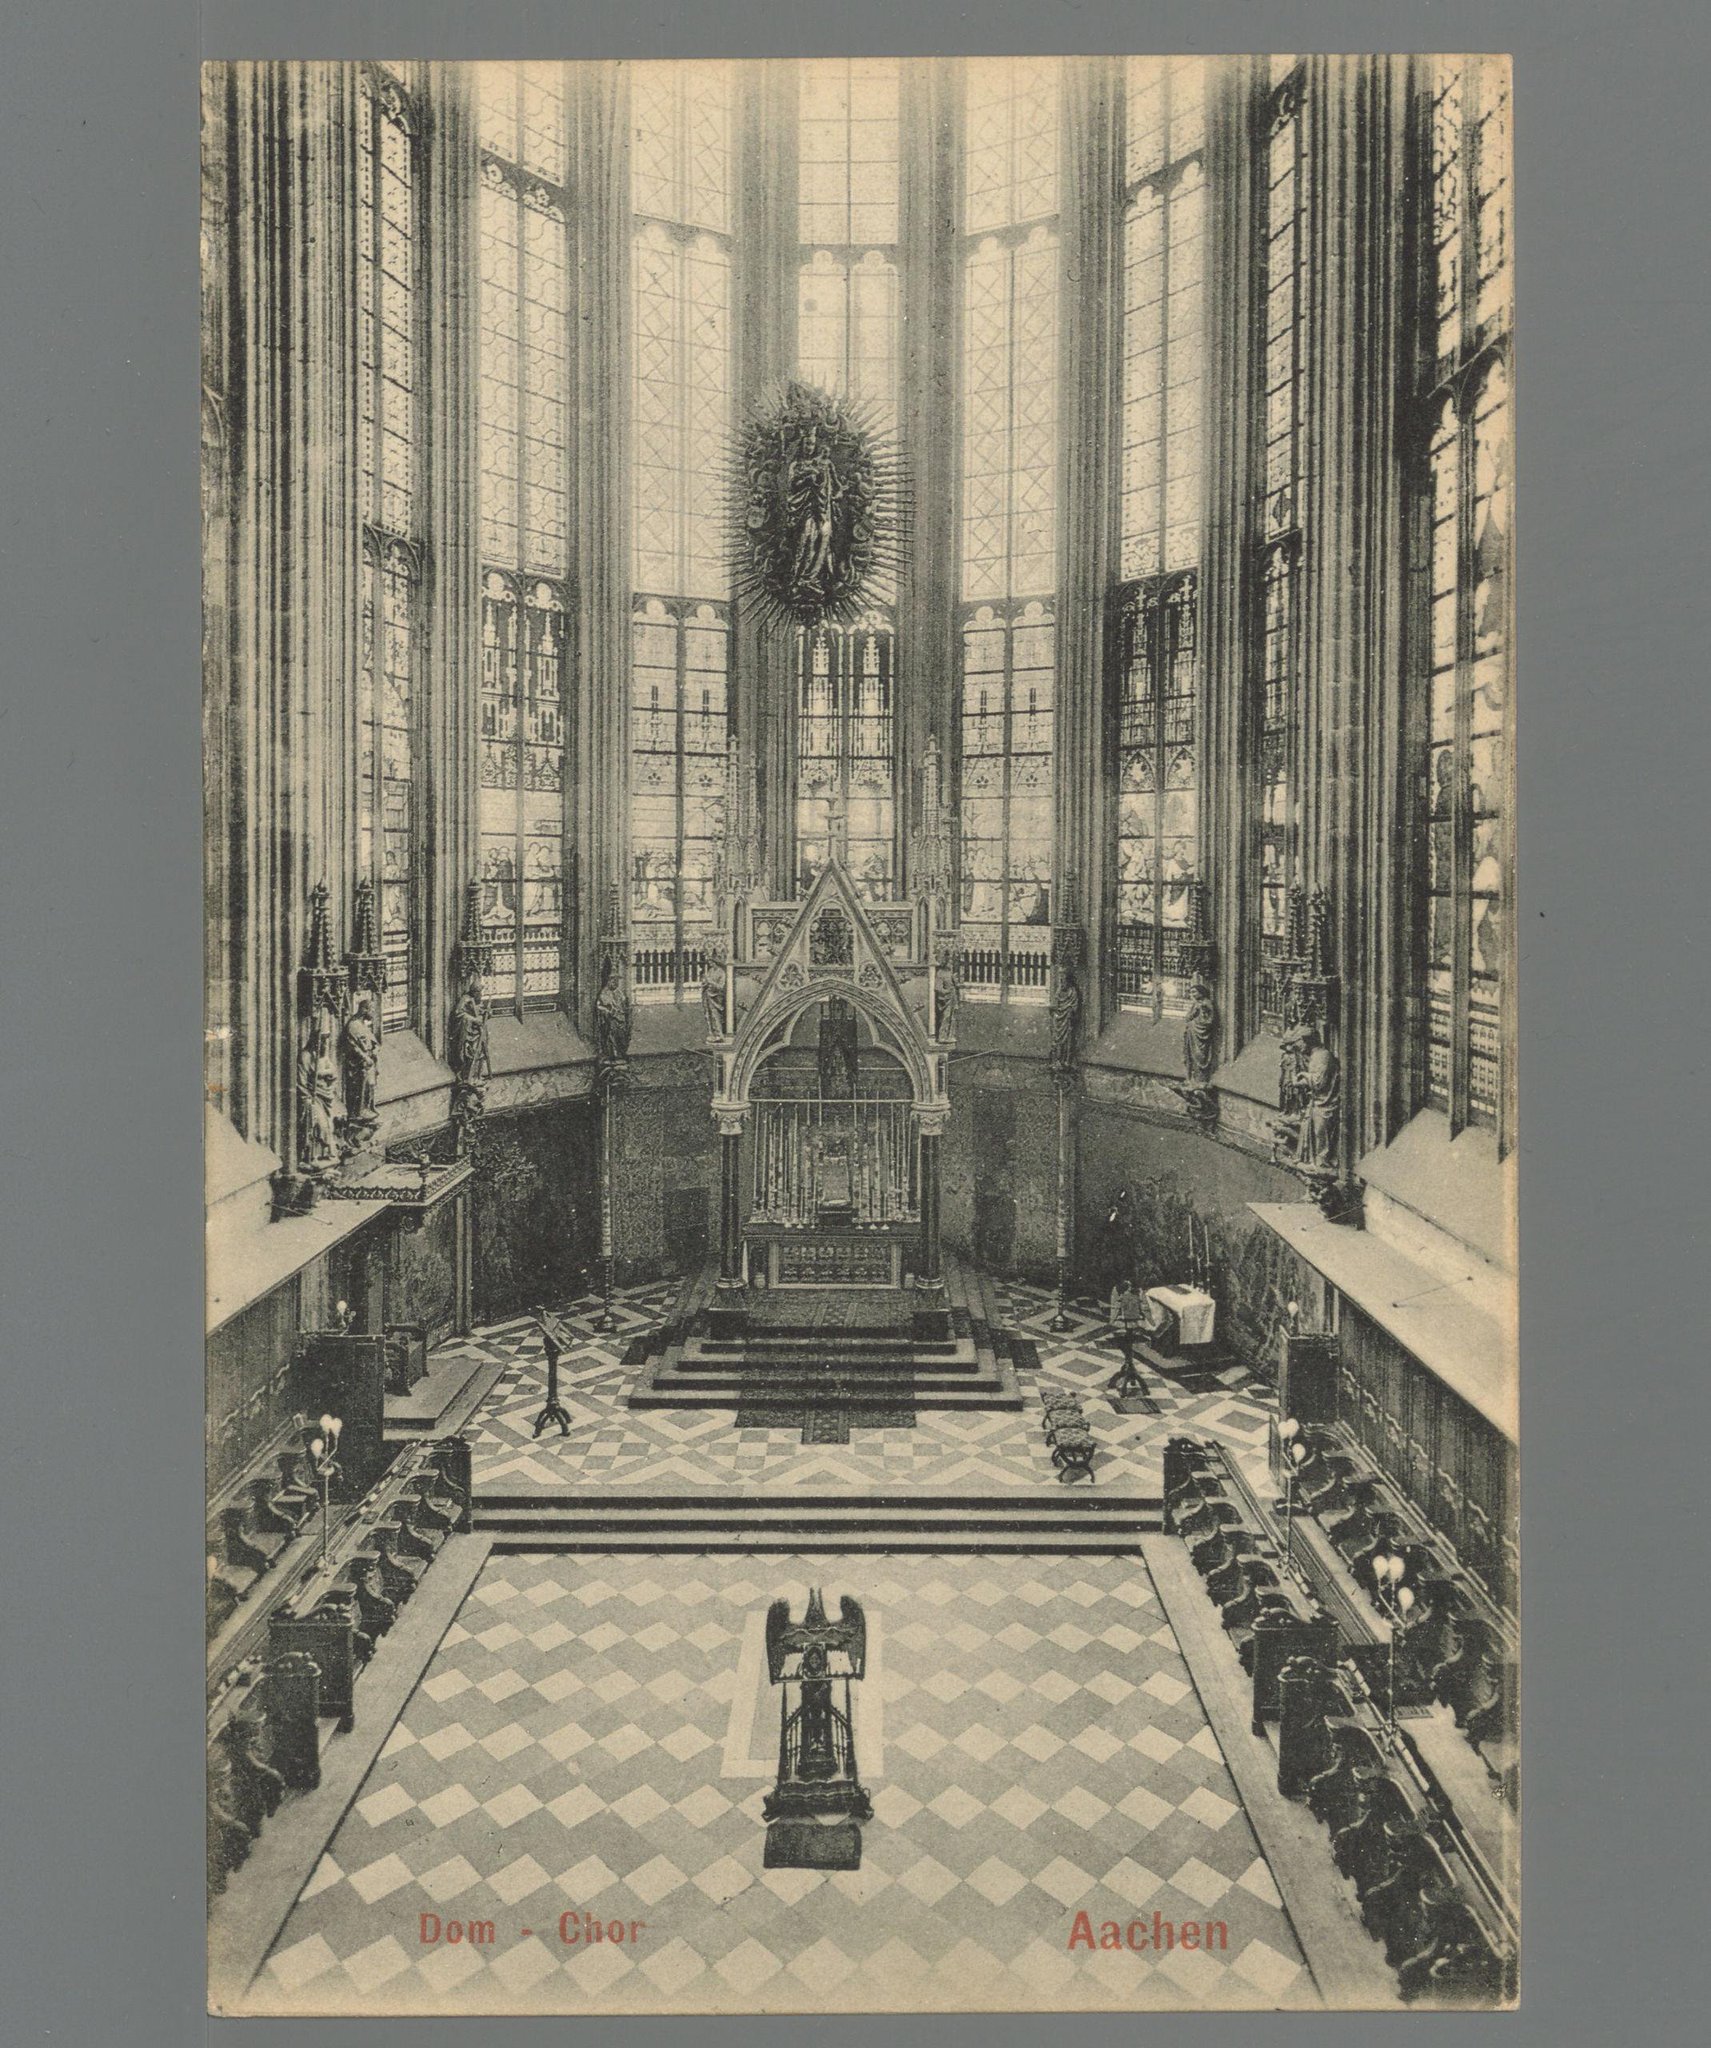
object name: ansichtkaart, prentbriefkaart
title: Dom - Chor. Aachen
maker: Anonymous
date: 1903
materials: cardboard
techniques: photograph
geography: dresden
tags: interior of church, parts of church interior: choir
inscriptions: date